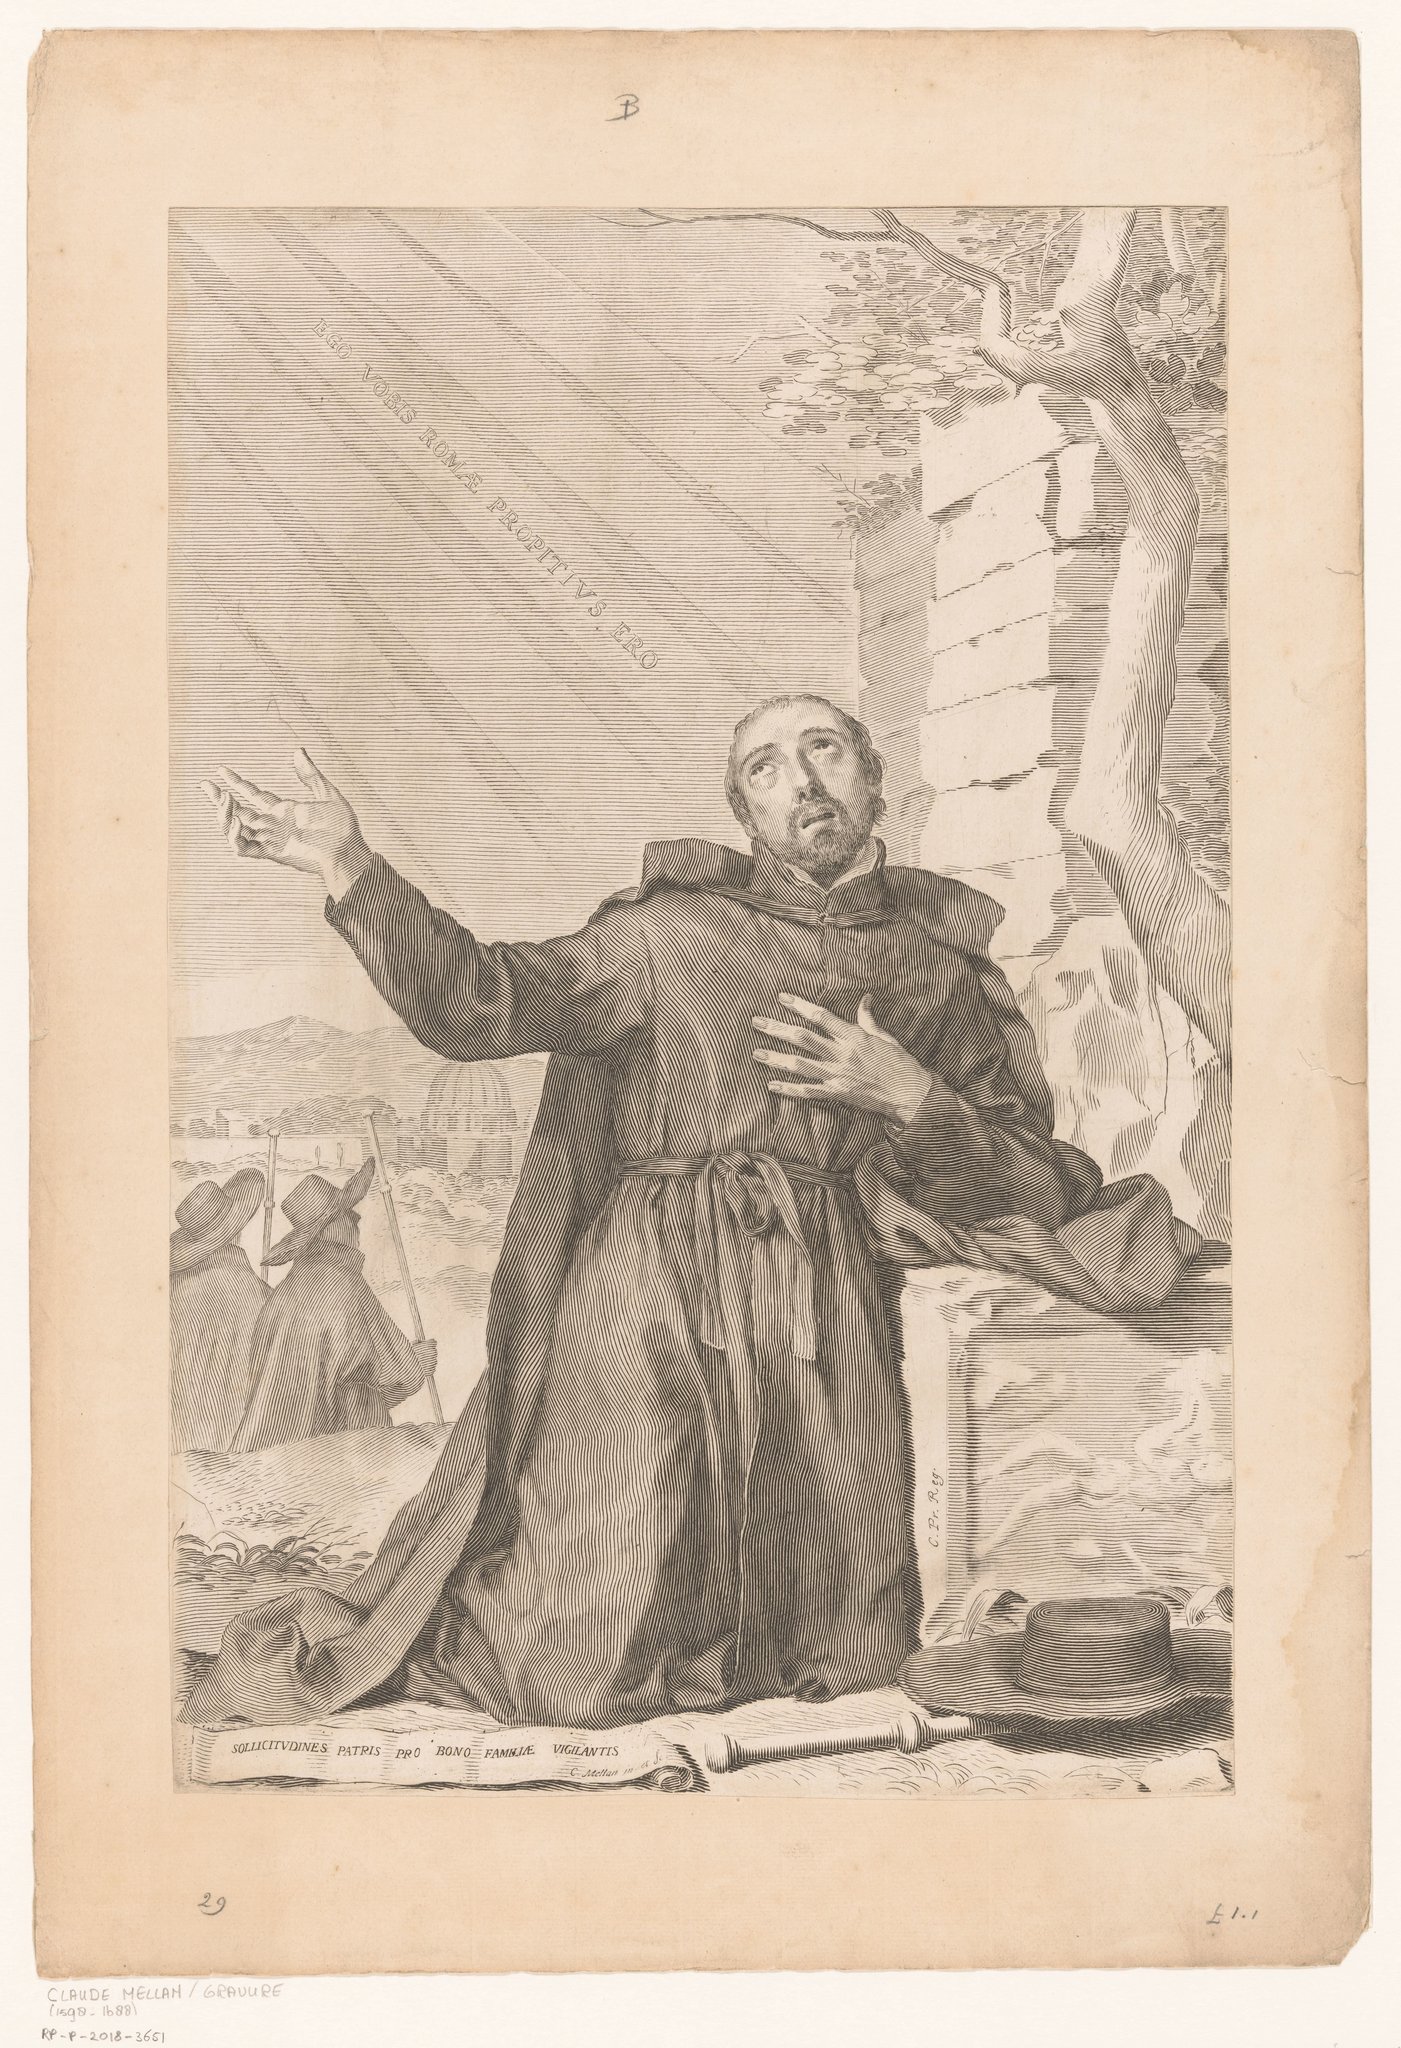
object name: print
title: H. Ignatius van Loyola in extase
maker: claude mellan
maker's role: draughtsman, print maker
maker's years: 1598-1688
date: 1608-1688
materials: paper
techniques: engraving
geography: france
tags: rome, clergyman, historical persons, pilgrimage, pilgrim(s) under way, visions of st. ignatius of loyola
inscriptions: collector's mark: Lugt 2228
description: De heilige Ignatius van Loyola, knielend in extase voor een blok met reliëf. Op de achtergrond links lopen pelgrims naar Rome.